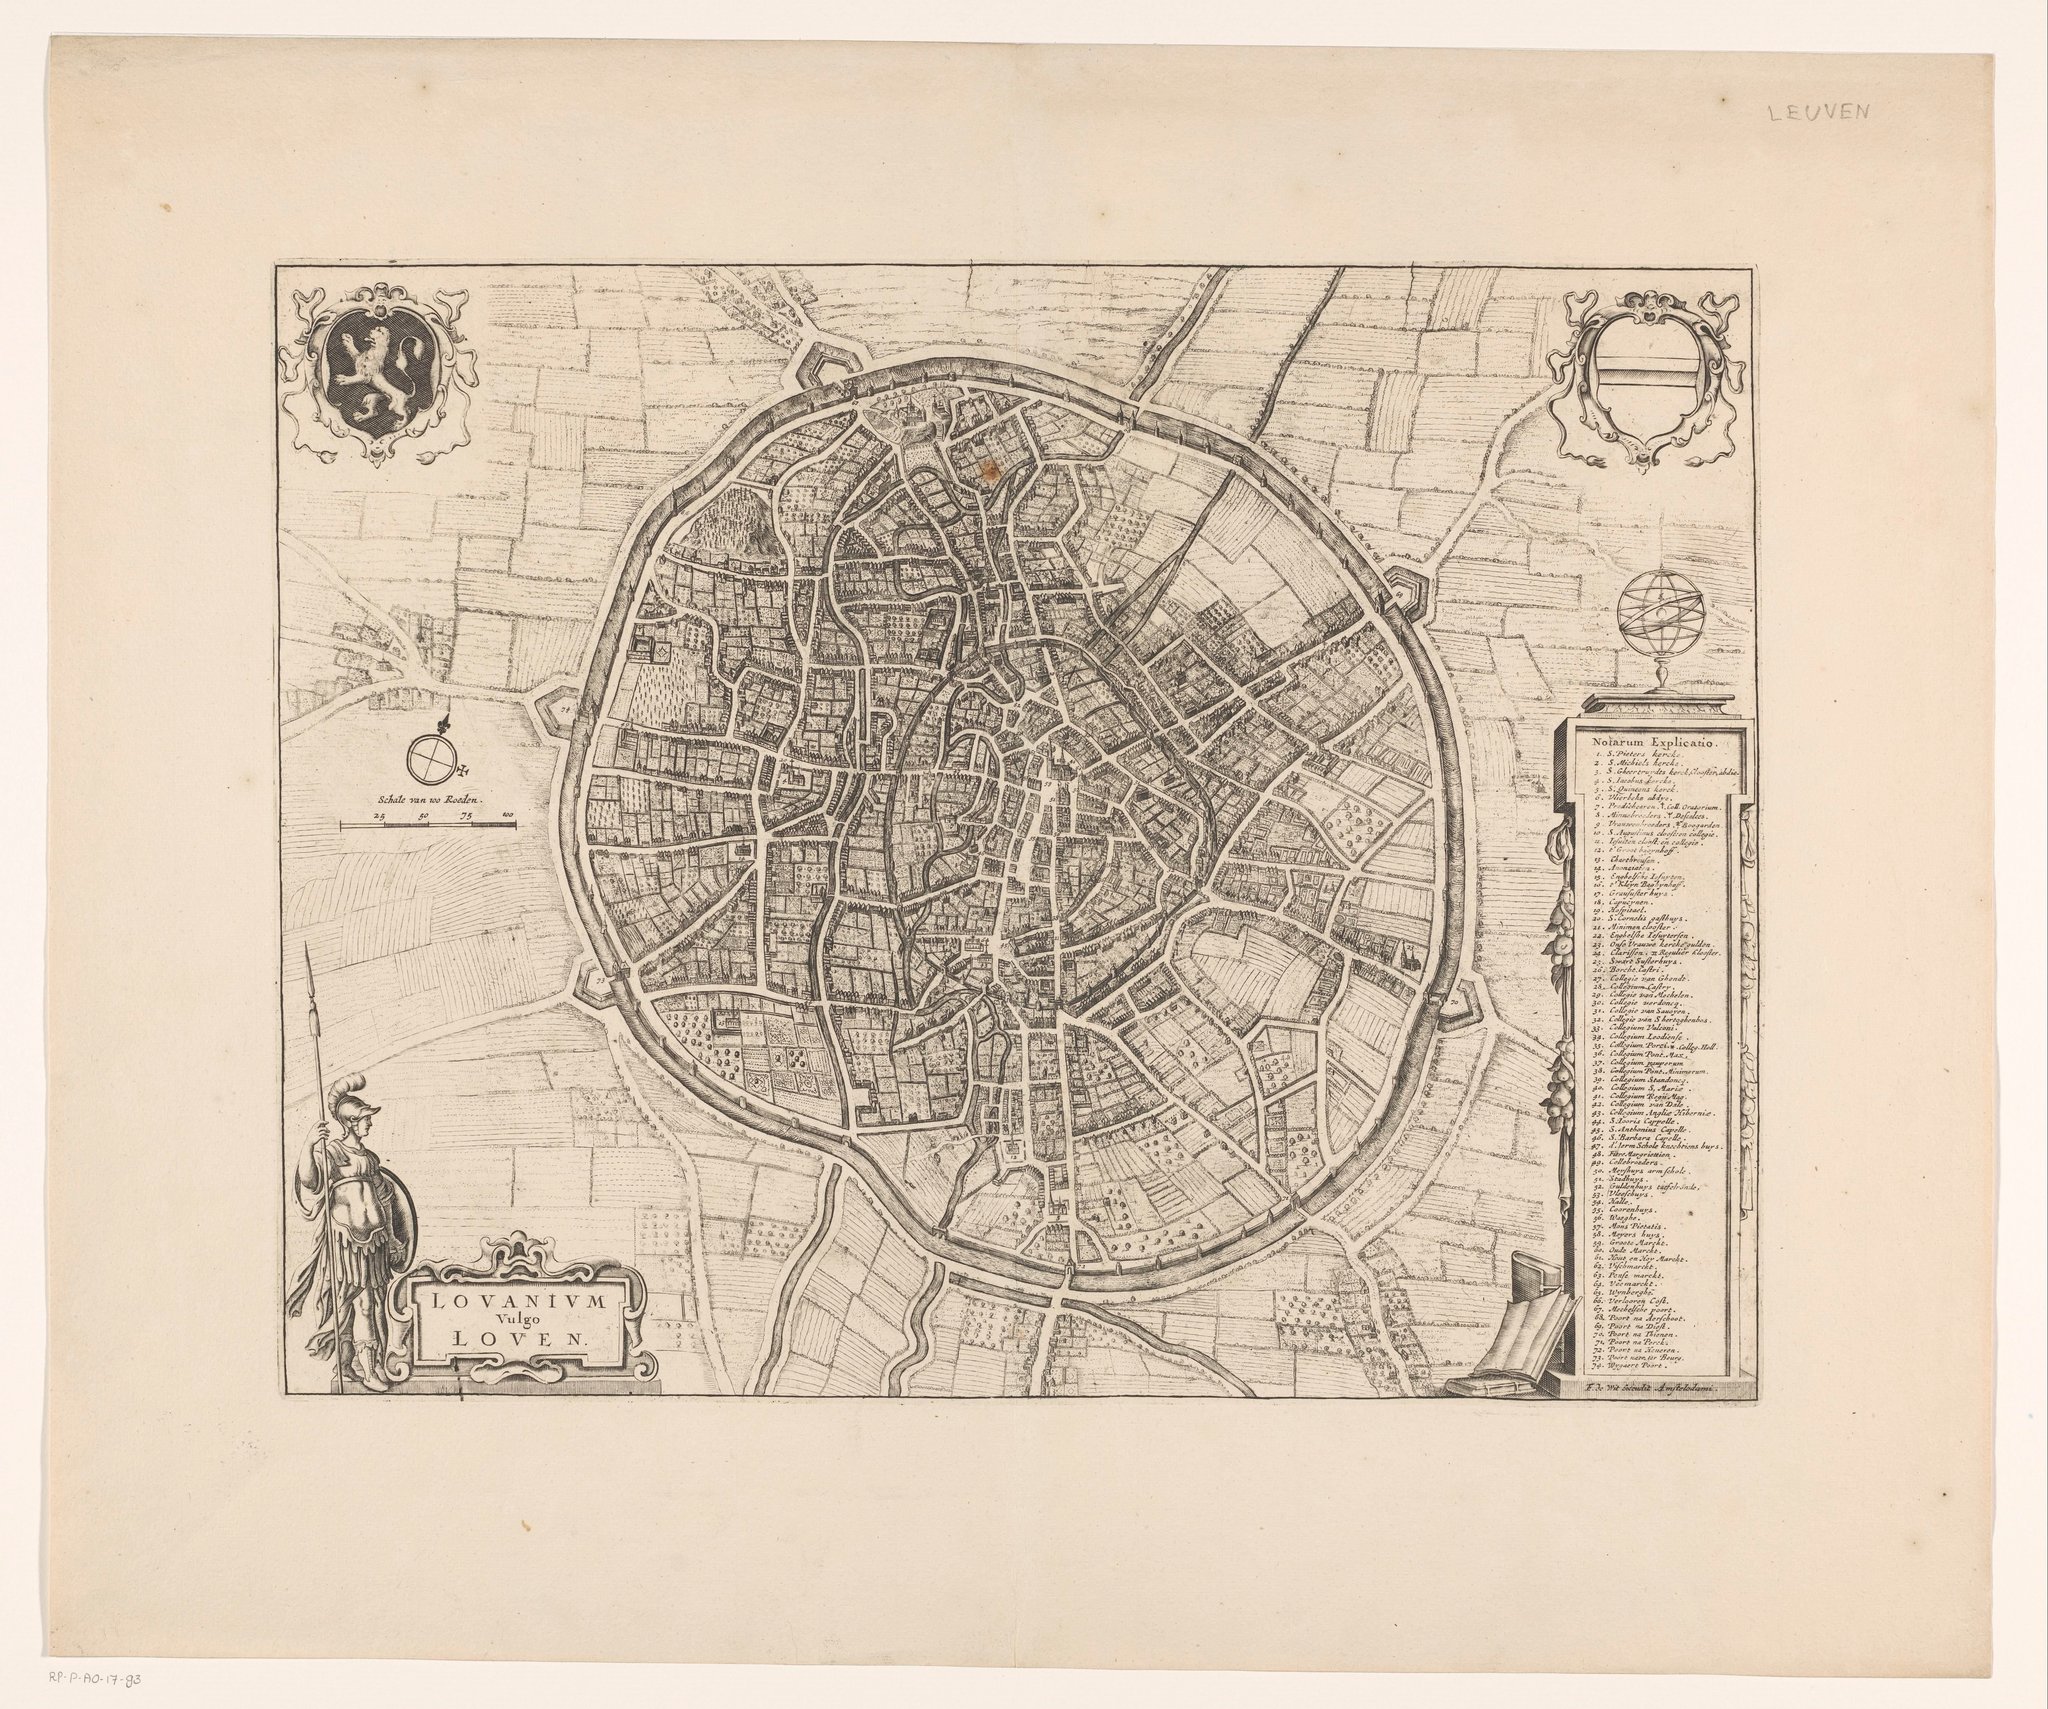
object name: area plan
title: Plattegrond van Leuven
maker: Anonymous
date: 1649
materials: paper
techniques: engraving, etching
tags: coat of arms (as symbol of the state, etc.) (+ city; municipal), maps of cities, coat of arms (as symbol of the state, etc.) (+ province; provincial), louvain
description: Huidige staat van prent ook gebruikt in: Theatrum ichnographicum omnium urbium et praecipuorum oppidorum Belgicarum XVII Provinciarum (…). Amsterdam: Frederik de Wit, ca. 1700-1710. En in: Aa, Pieter van der. La galerie agreable du monde (…). 66 delen. Leiden: Pieter van der Aa, 1728, dl. 16.